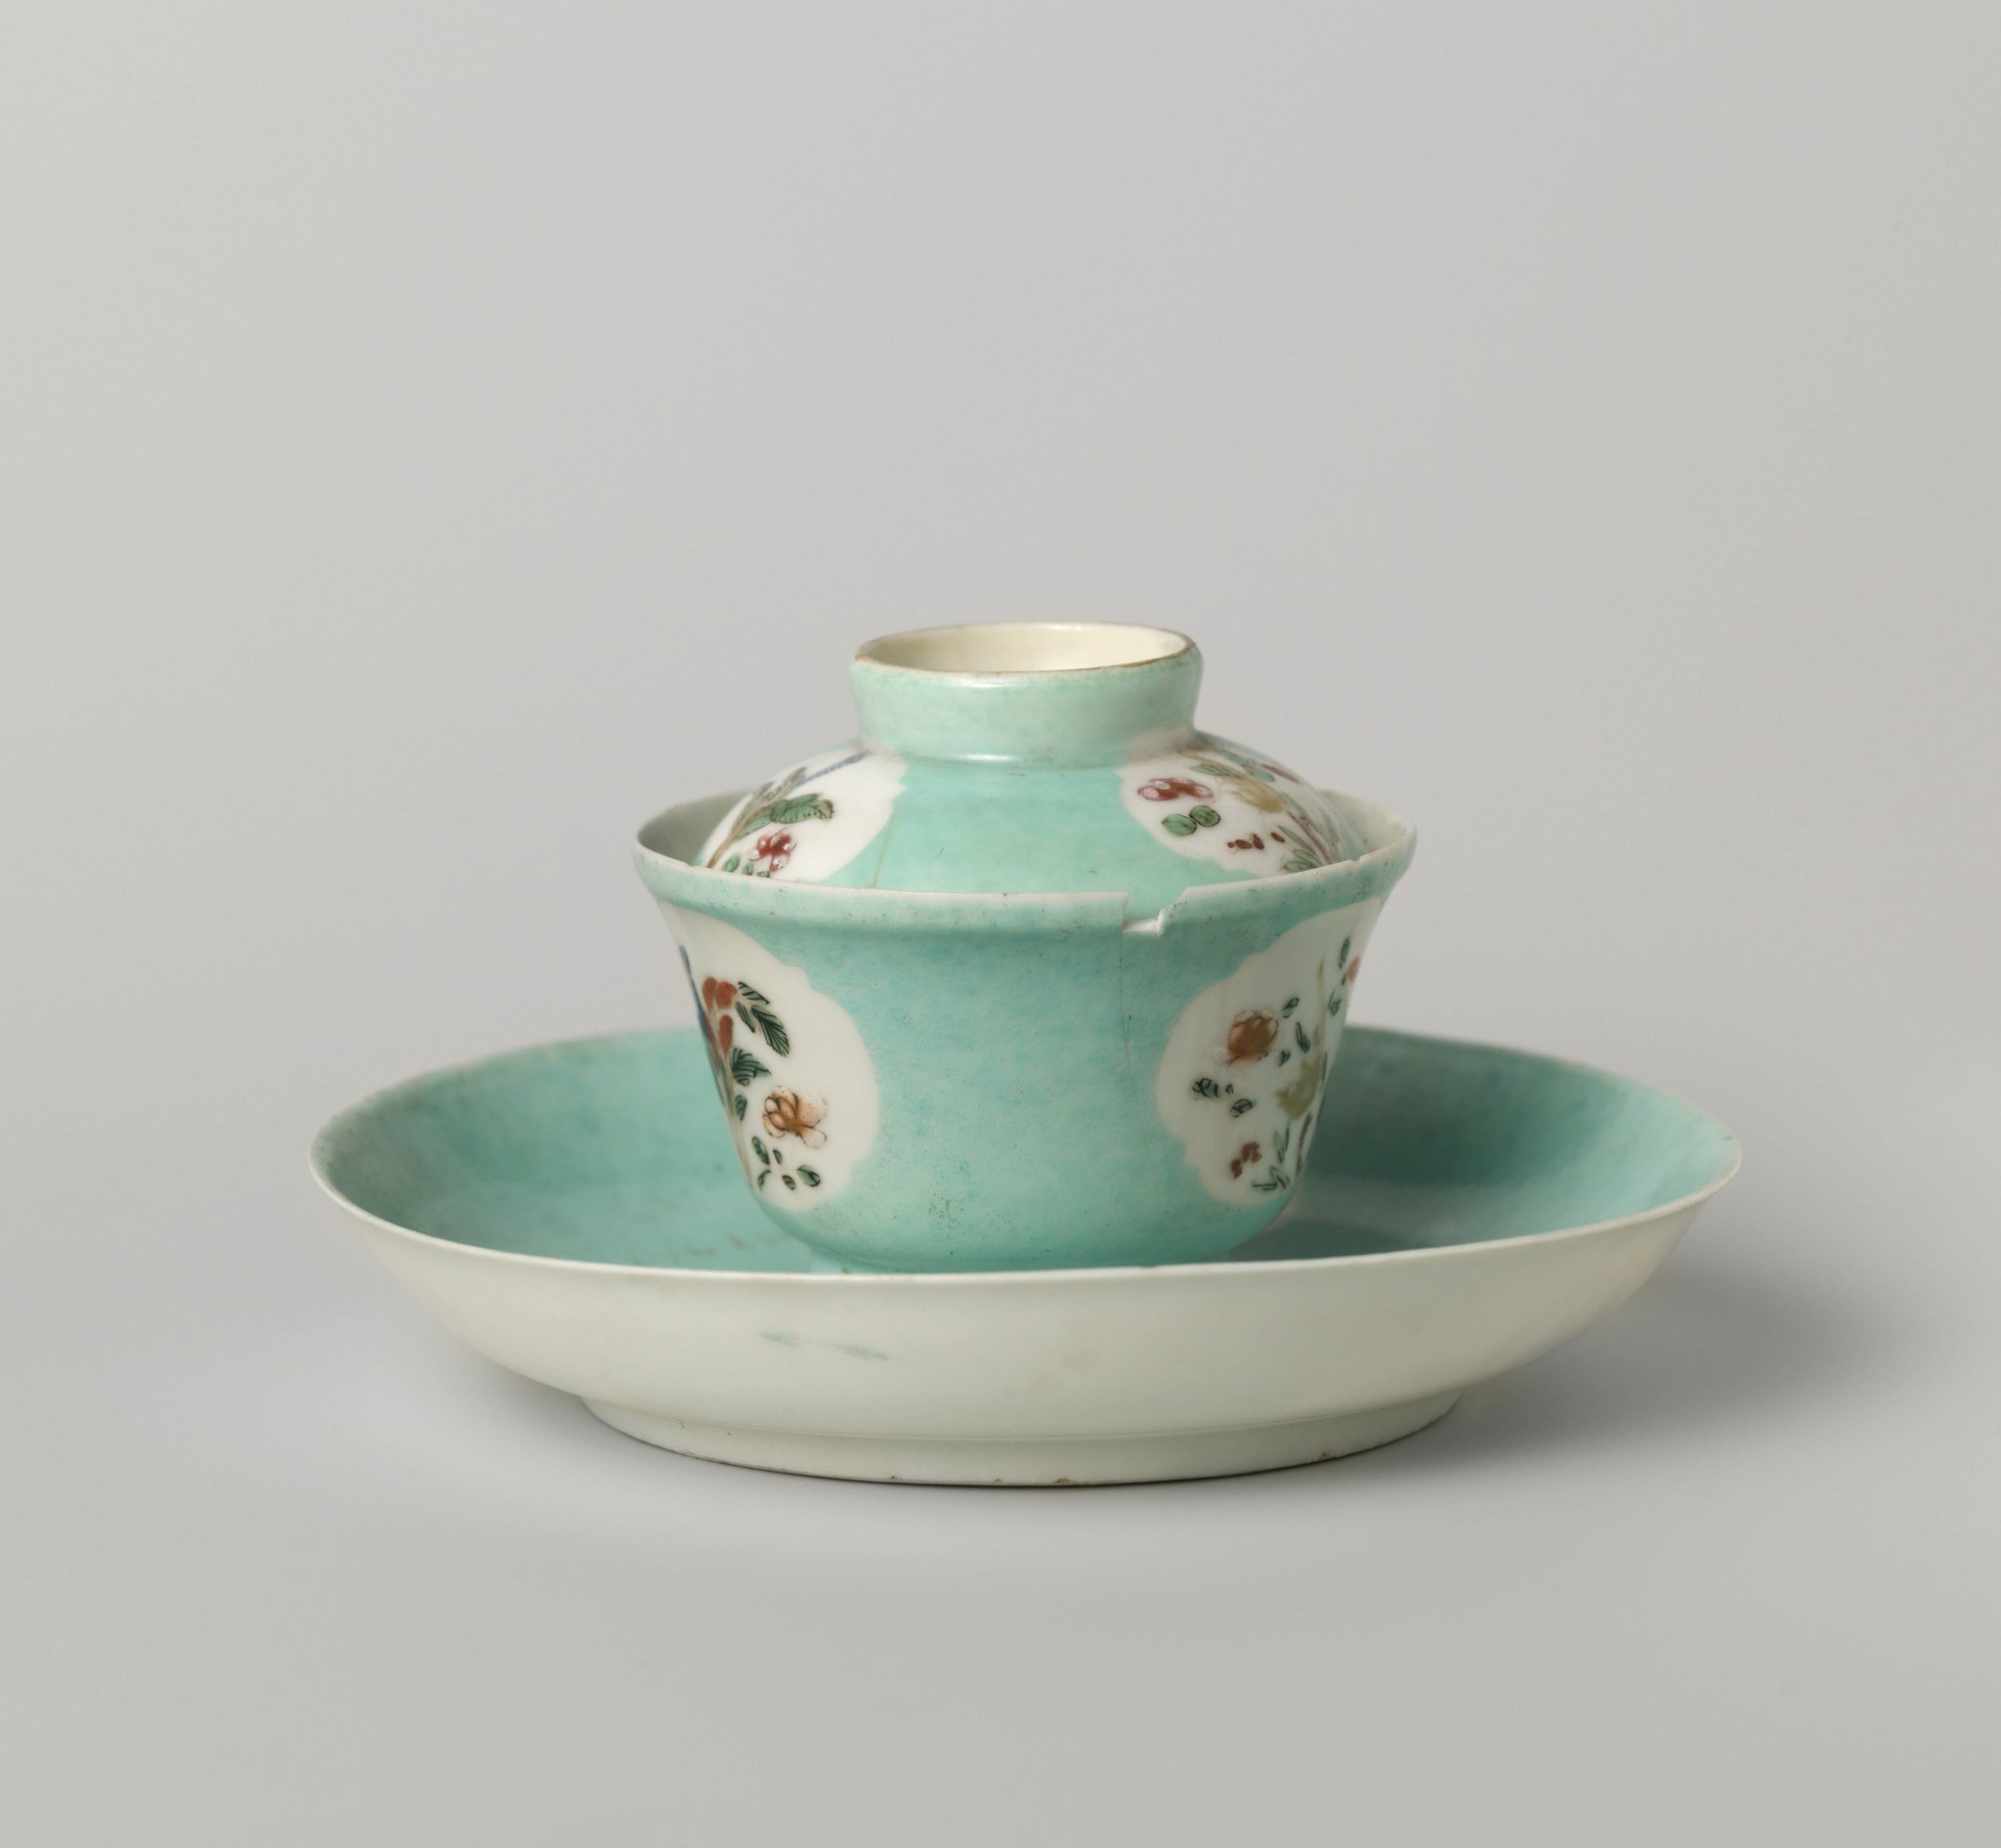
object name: kop en schotel, kop en schotel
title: Bell-shaped covered cup and saucer with flowering plants in shaped panels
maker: Anonymous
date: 1760-1780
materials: glaze, gold, paint, porcelain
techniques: firing, gilding, turning, vitrification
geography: china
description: Klokvormige kop en schotel van porselein, bedekt met een turquoise glazuur en berschilderd in blauw, rood, roze, groen, zwart en goud. De schotel is aan de voorzijde bedekt met een turquoise glazuur met hierin uitgespaard in het centrum een geschulpt medaillon met plant, daaromheen drie uitgespaarde cartouches met bloeiende planten en een vogel op een tak. Kop en deksel met dezelfde decoratie. Een barst in de wand van de kop en scherf missen uit de rand; dekselmet enkele barsten en chips. Famille rose.